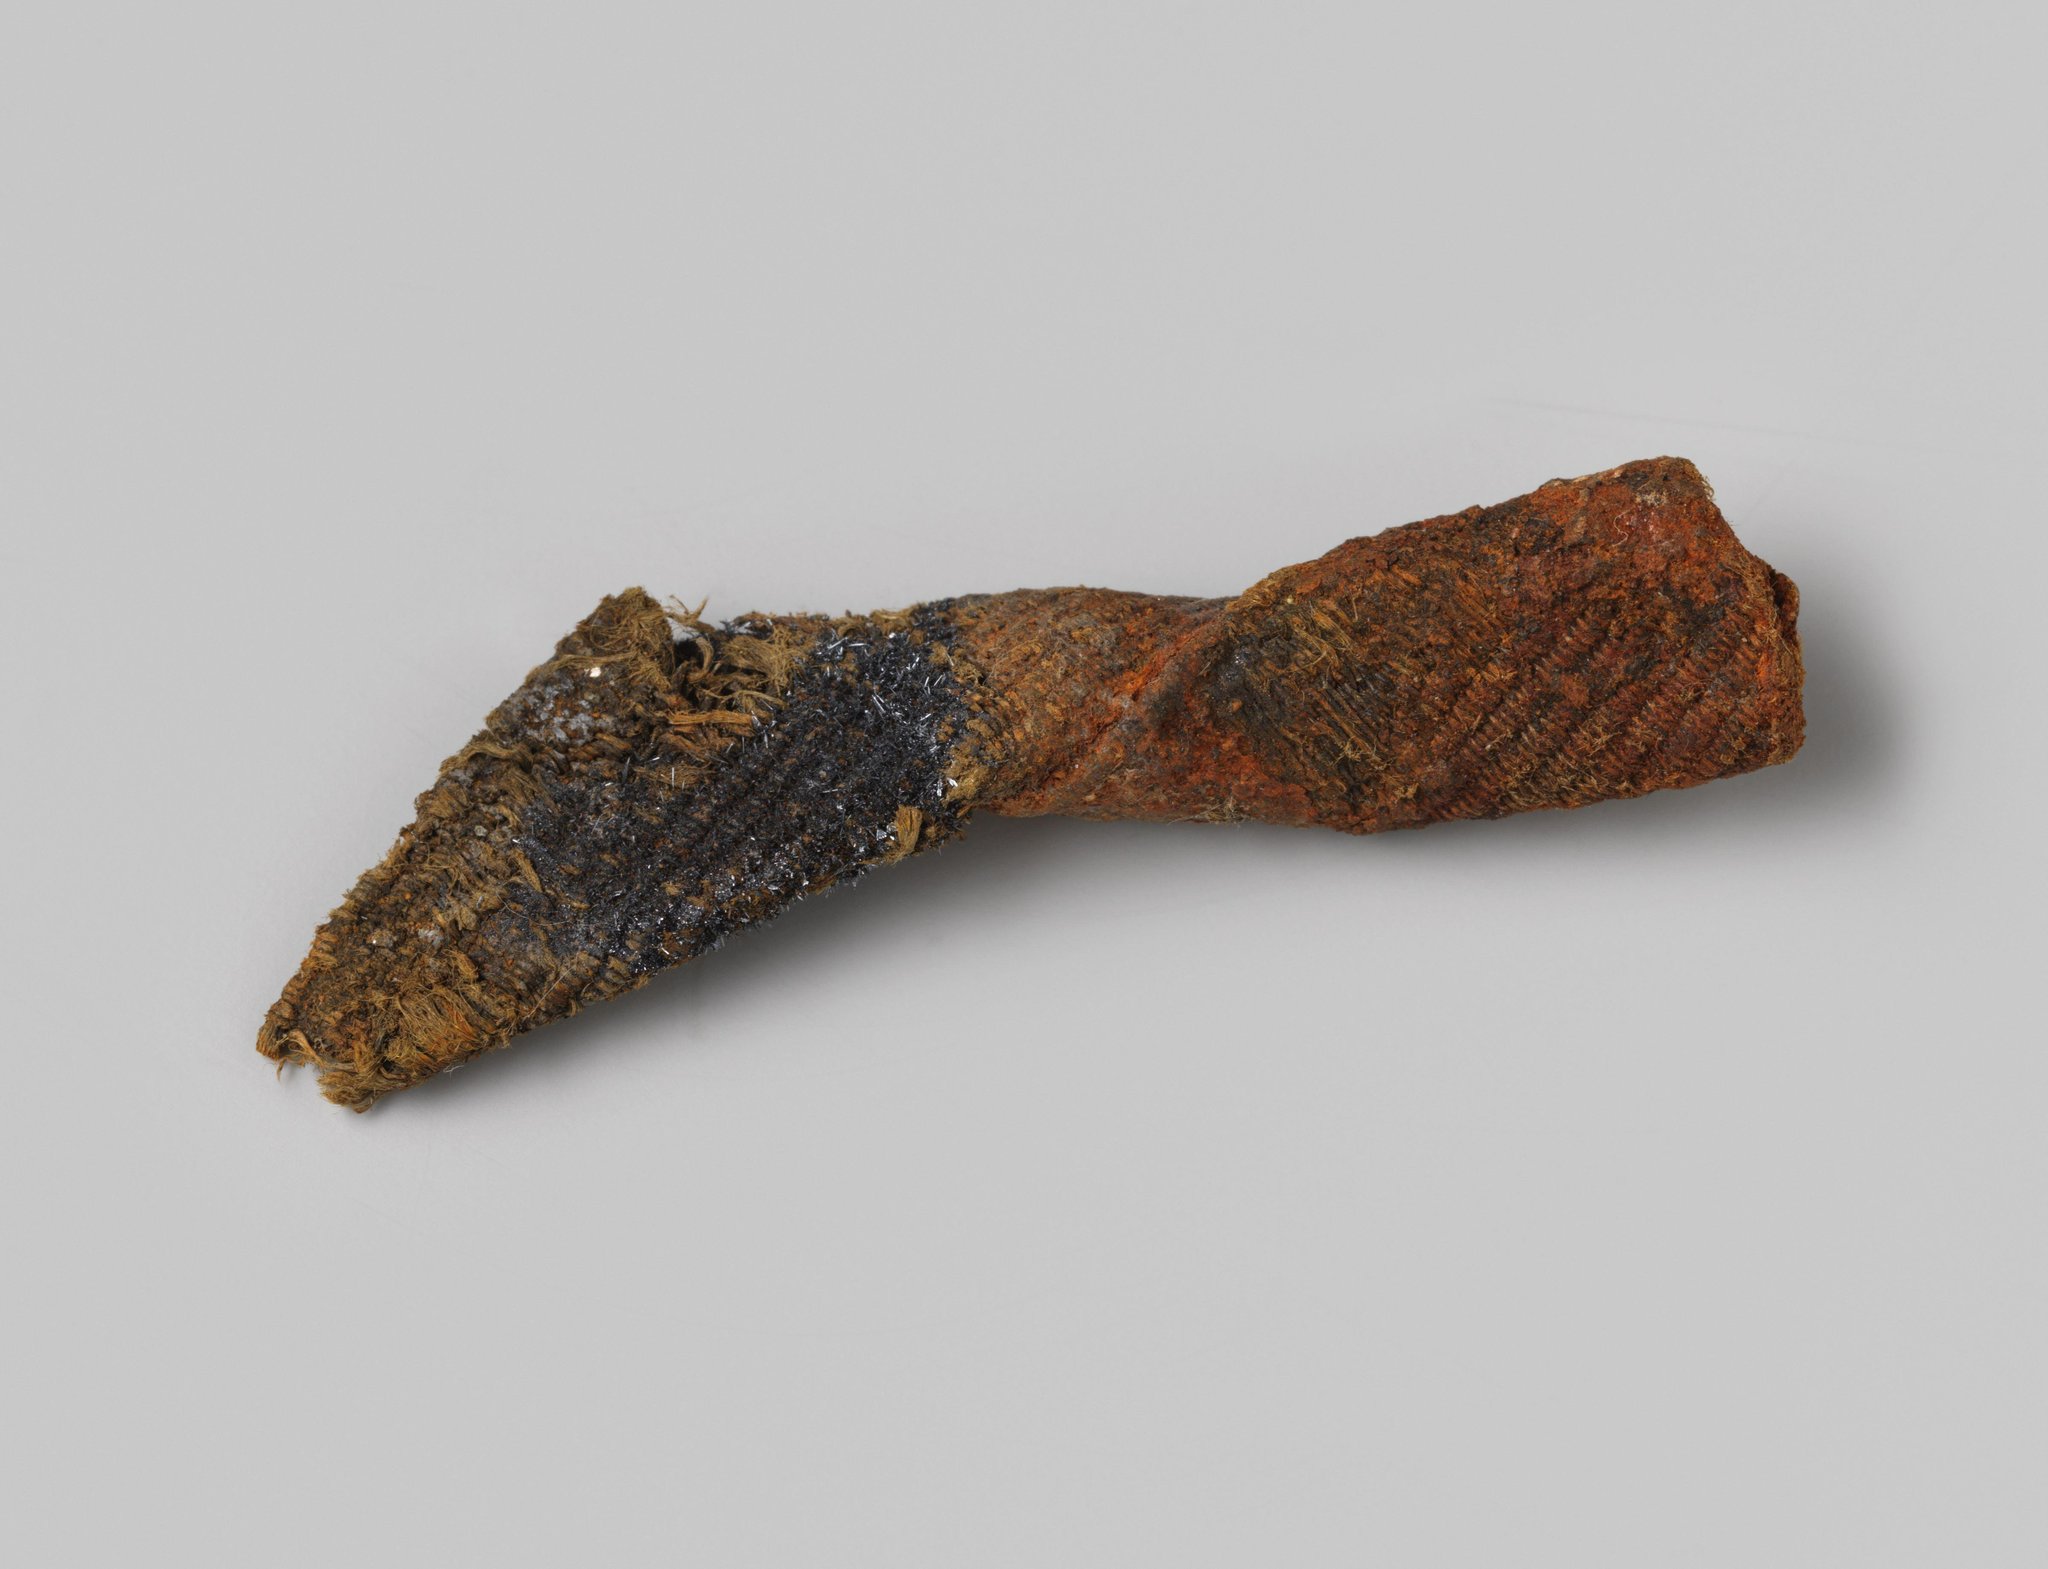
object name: fragment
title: Fragment van textiel uit het wrak van de Oost-Indiëvaarder Hollandia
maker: Anonymous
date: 1700-1743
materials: textile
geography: netherlands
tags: verenigde oostindische compagnie, hollandia (schip), annet